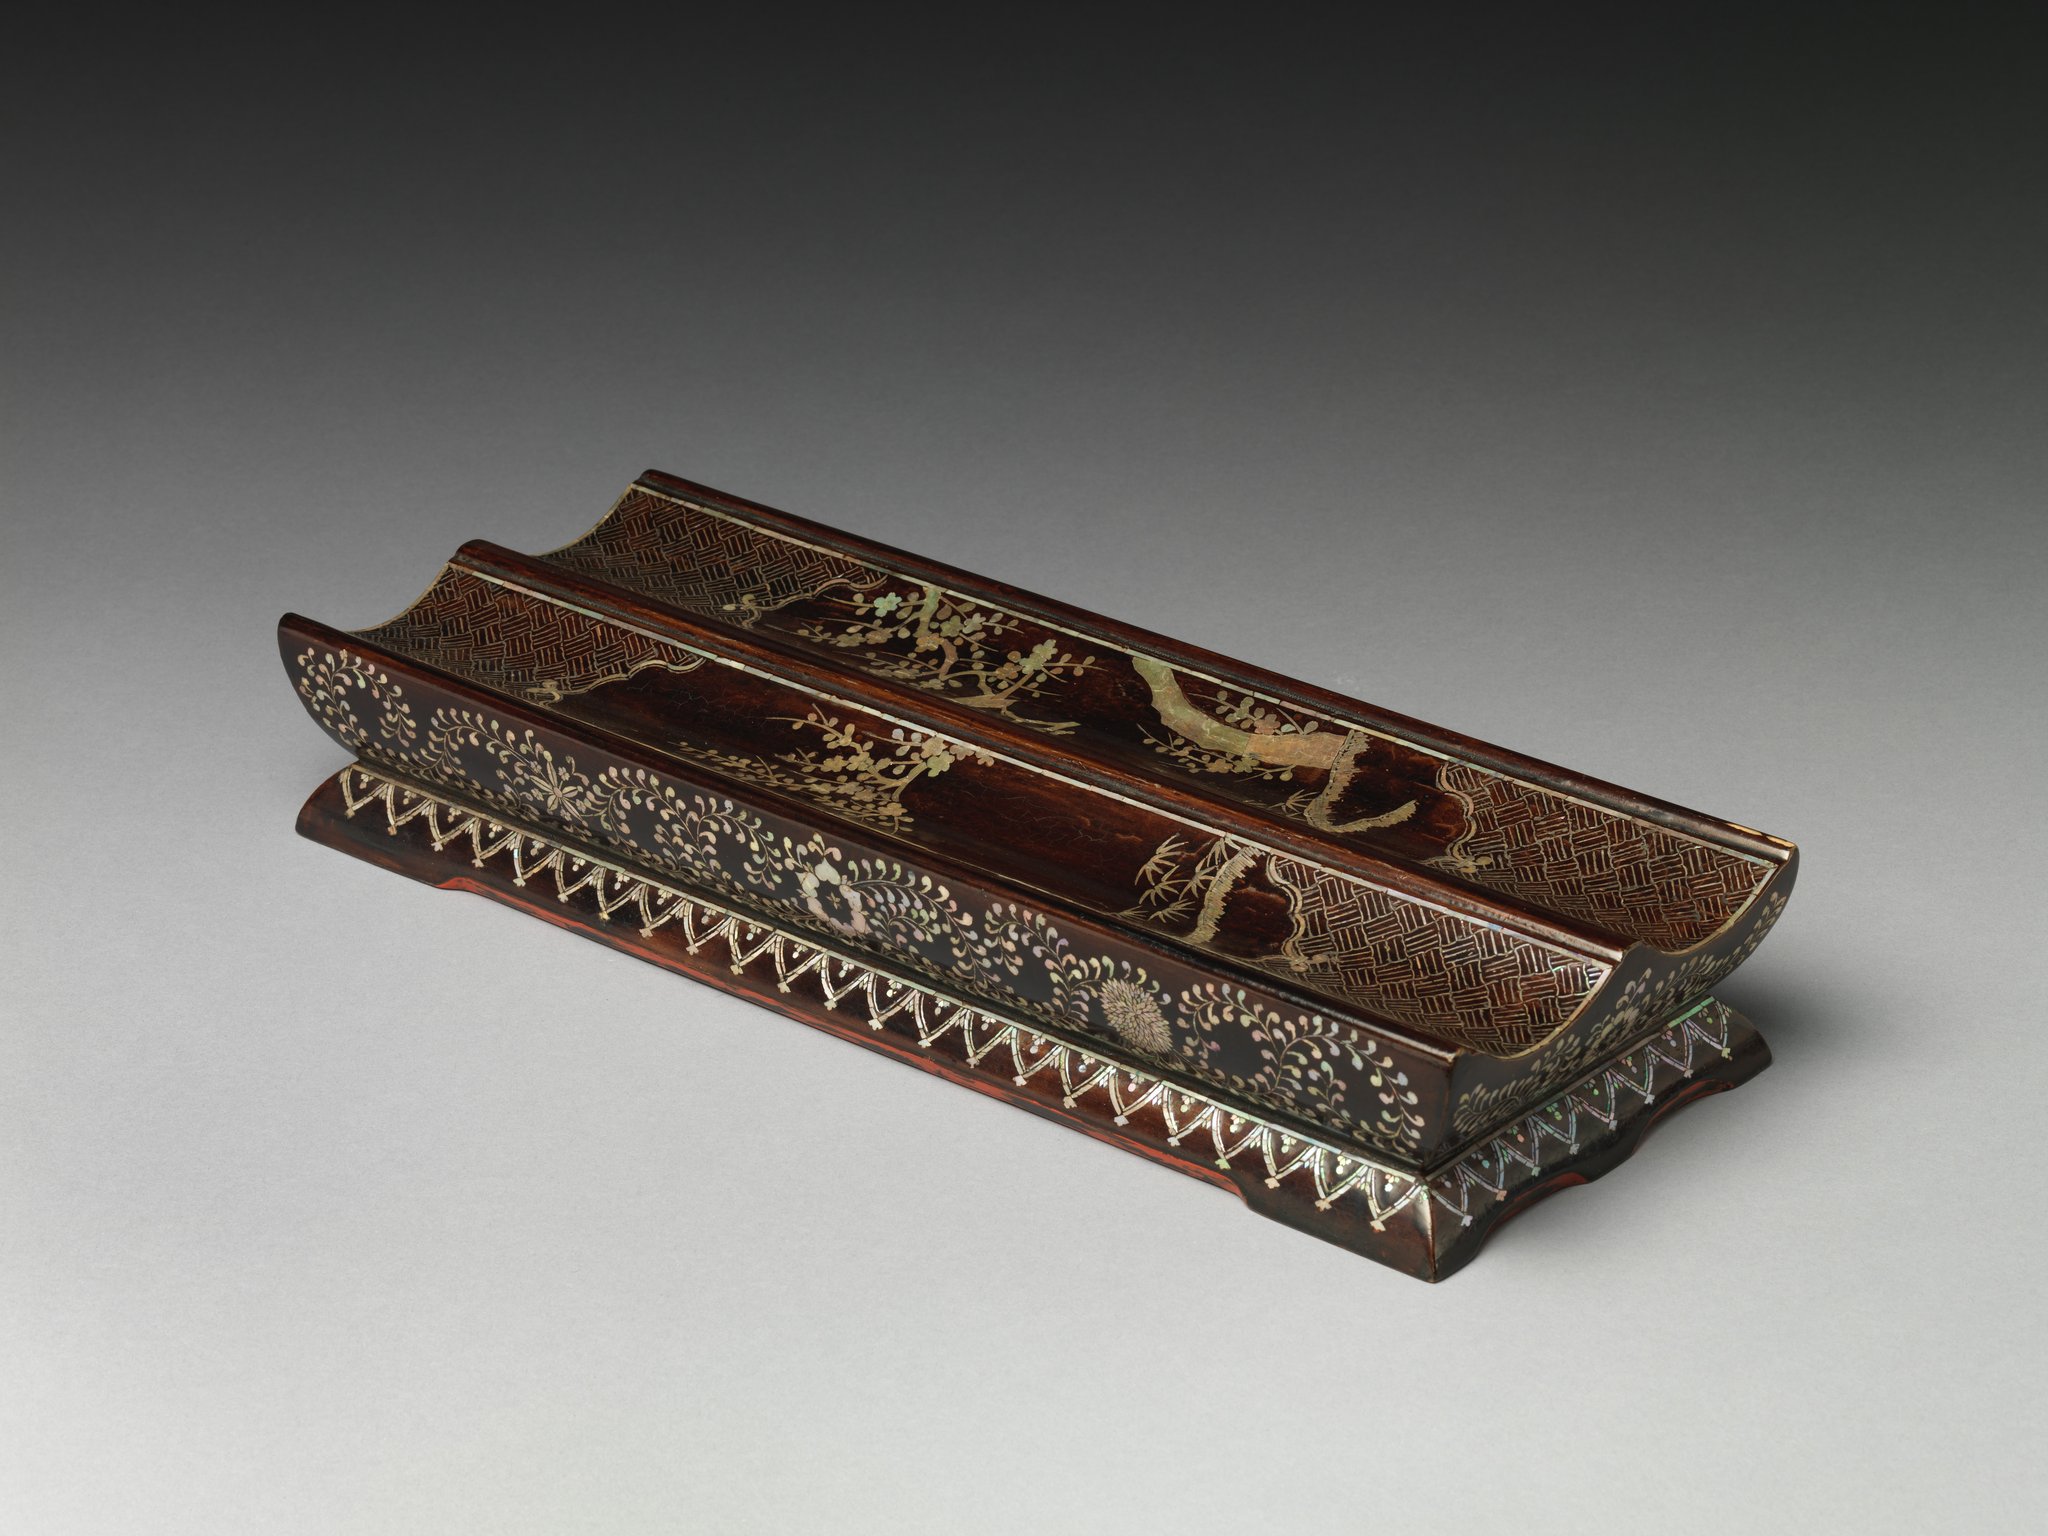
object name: tray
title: Scroll tray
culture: chinese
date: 1573-1620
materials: lacquer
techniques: inlay